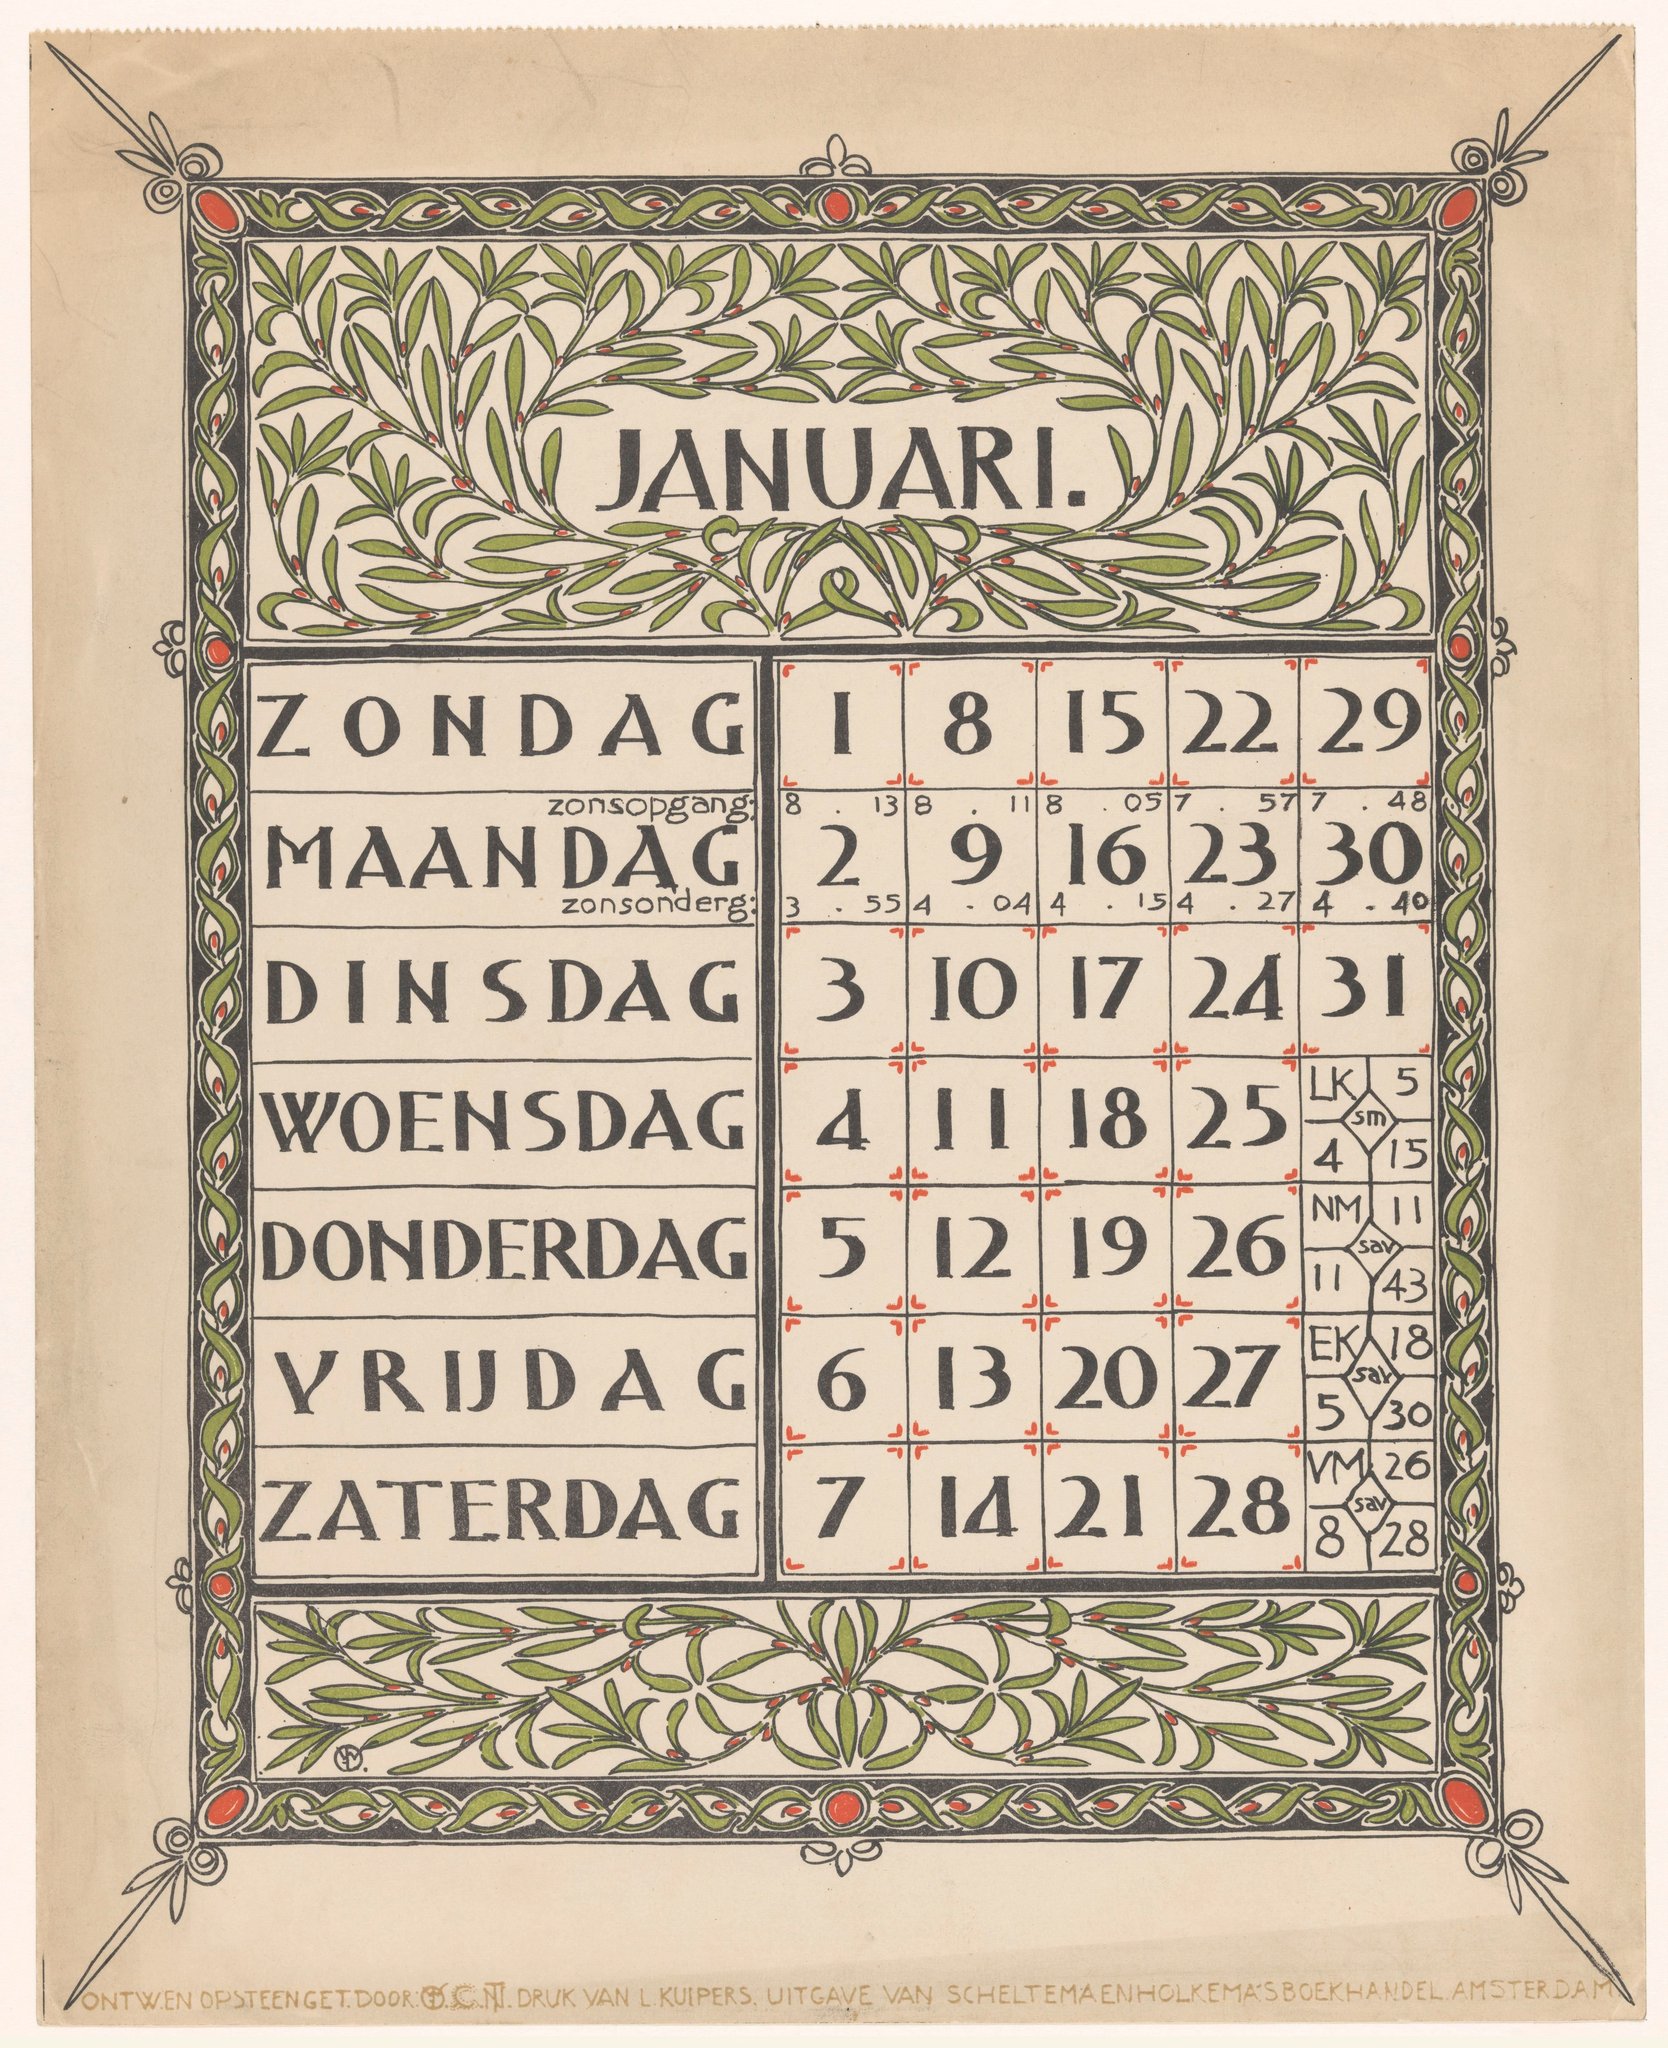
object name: calendar leaf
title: Kalenderblad voor januari 1899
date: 1898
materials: paper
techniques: lithograph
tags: foliage, tendrils, branches ~ ornament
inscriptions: collector's mark: Lugt 2228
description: In 1898 vervaardigden Gerrit Willem Dijsselhof, Carel Adolph Lion Cachet en Theo Nieuwenhuis samen een kalender voor het jaar 1899. Dijsselhof nam het ontwerp van de maanden januari, april, juli en oktober op zich.